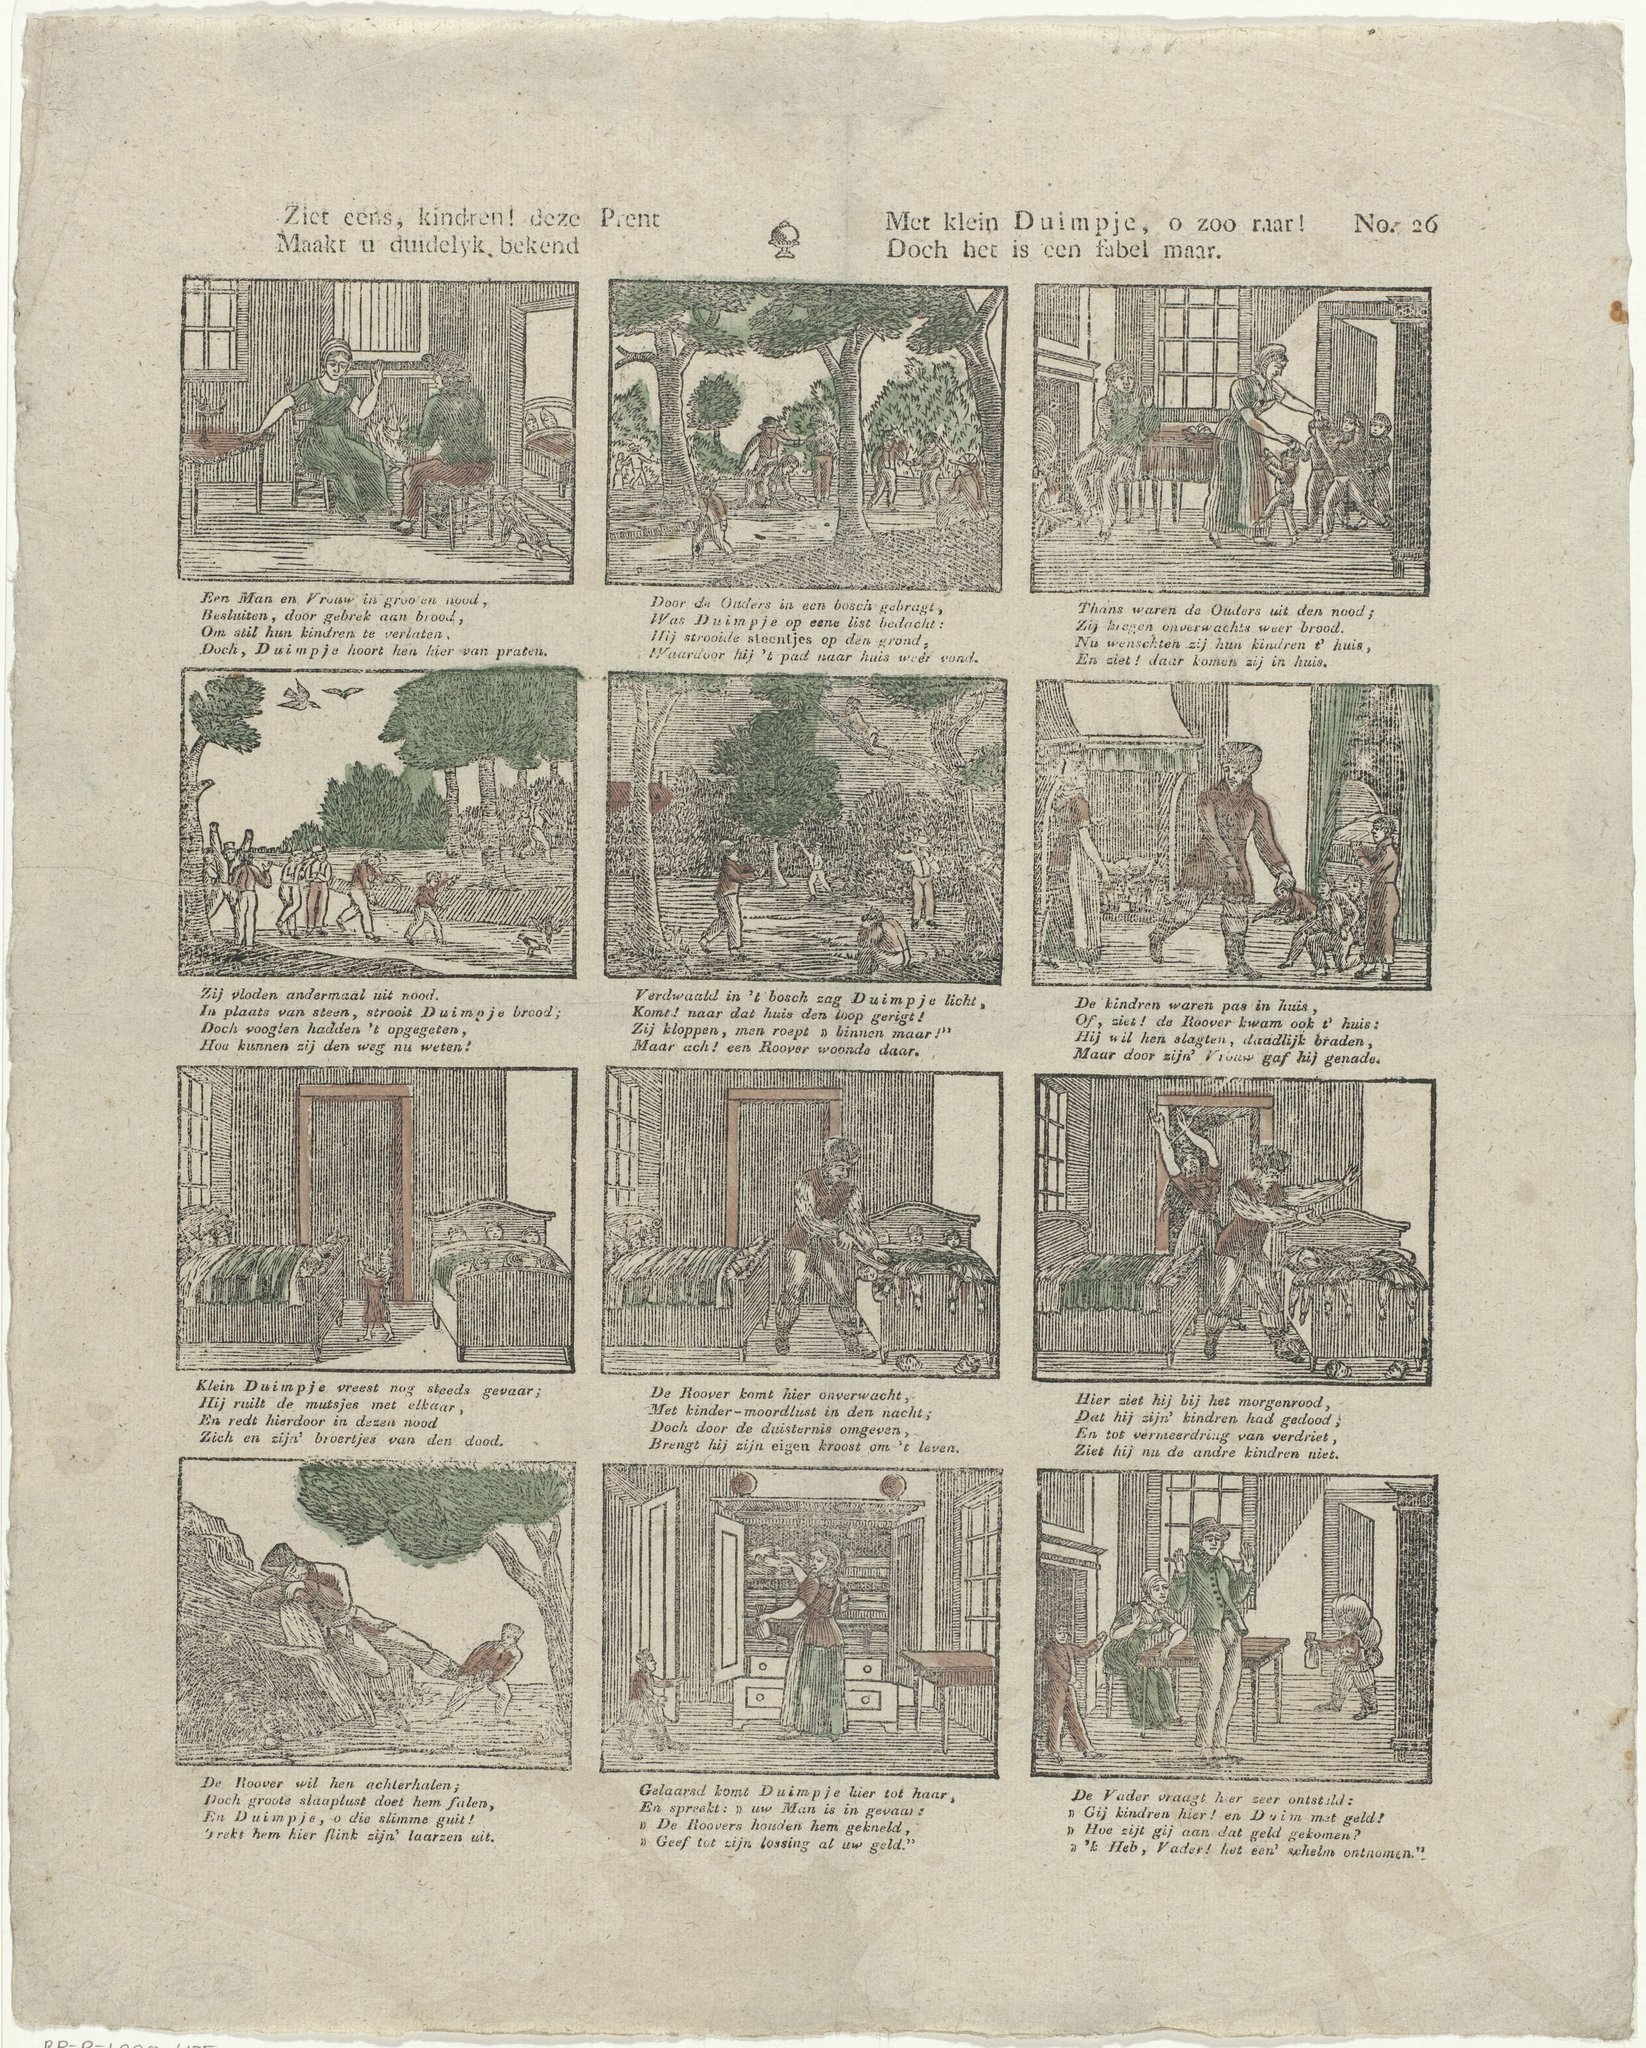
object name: popular print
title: Ziet eens, kindren! deze prent / Maakt u duidelyk bekend / Met klein duimpje, o zoo raar! / Doch het is een fabel maar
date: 1820-1837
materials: paper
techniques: colour, letterpress printing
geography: netherlands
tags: tales and fairy tales, tales and fairy tales: little thumbling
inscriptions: collector's mark: Lugt 2228, collector's mark: Lugt 2760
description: Blad met 12 voorstellingen uit het sprookje van Klein Duimpje. Onder elke voorstelling een vierregelig vers. Genummerd rechtsboven: No. 26.